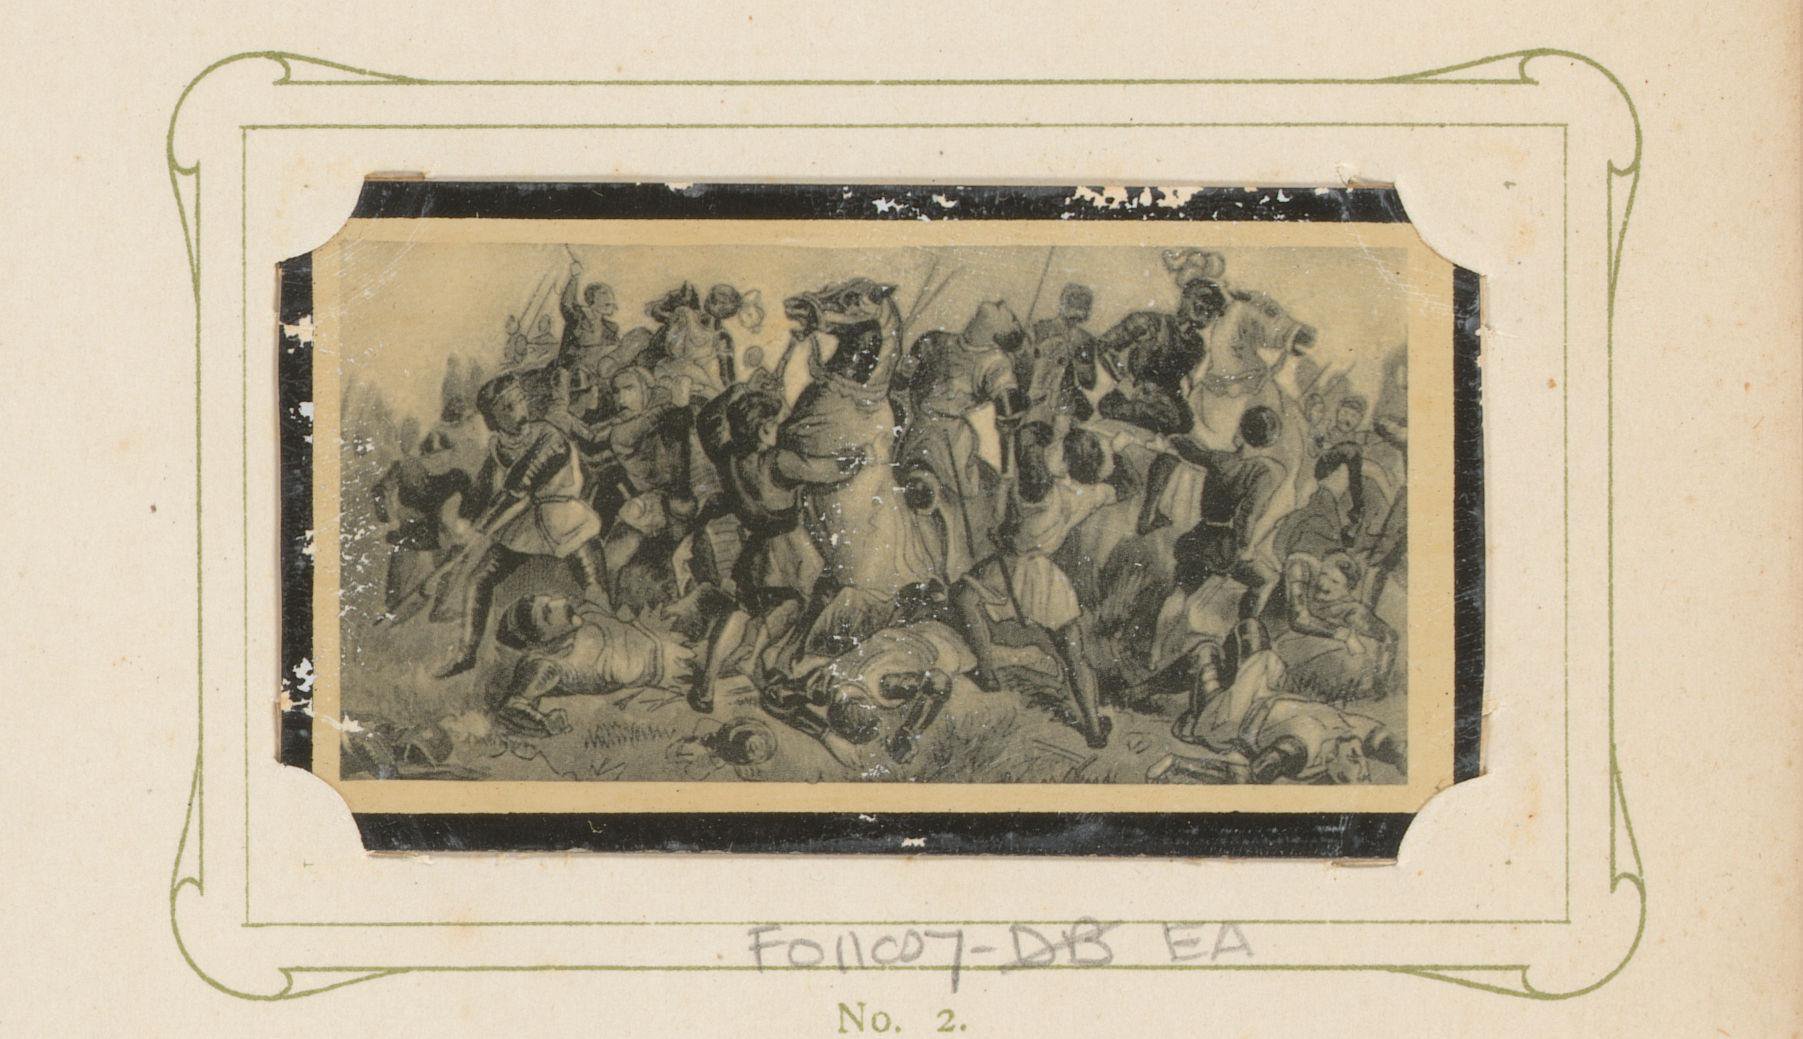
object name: reproduction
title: Reproductie van een tekening van een gevecht tussen de Hoeken en de Kabeljauwen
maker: Anonymous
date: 1905-1906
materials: paper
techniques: photograph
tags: battle, nobility and patriciate; chivalry, knighthood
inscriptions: inscription: ‘No. 2./ Hoeksche en Kabeljauwse twisten.’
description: Deze prent maakt deel uit van een album.